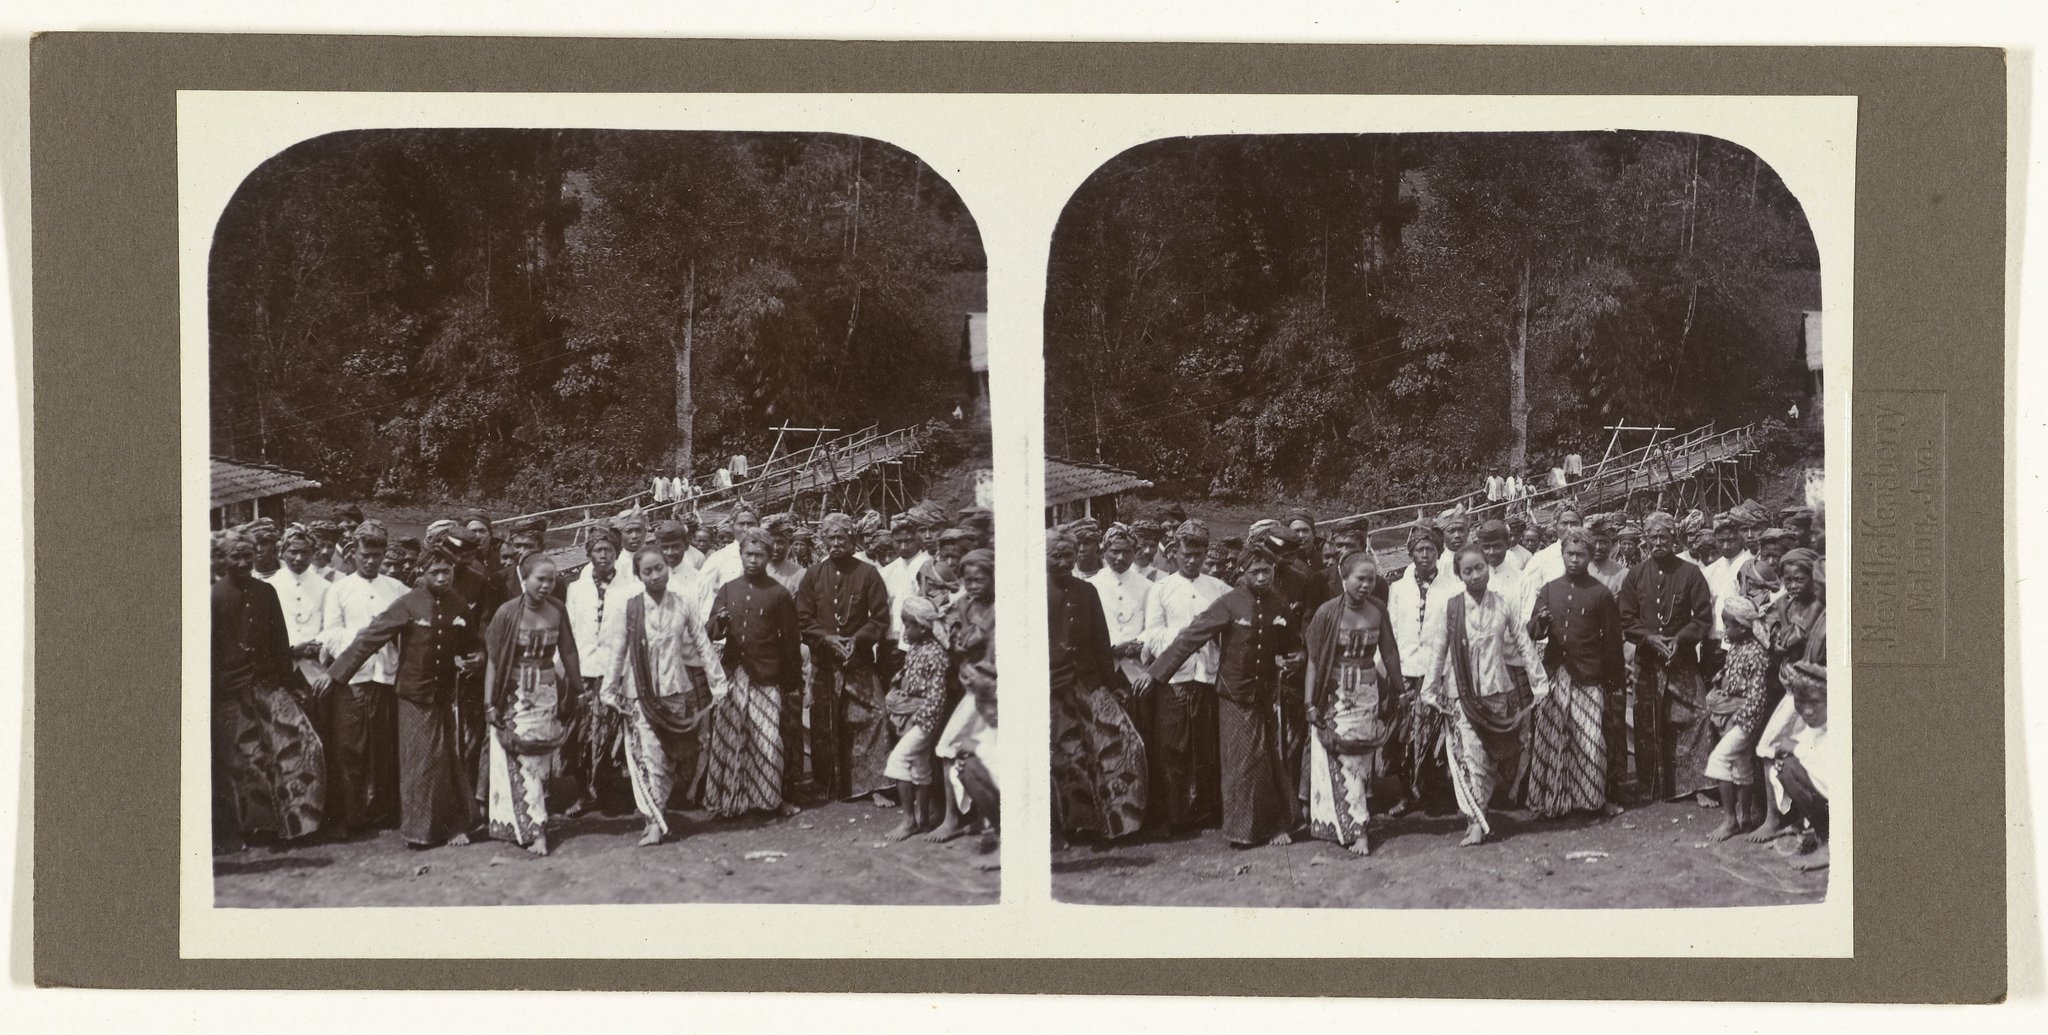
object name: stereograph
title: S 1 No 9. Volksvermaak. Een tandak partij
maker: neville keasberry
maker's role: fotograaf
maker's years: 1866-1944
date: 1900-1935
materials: cardboard, paper, photographic support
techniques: albumen print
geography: malang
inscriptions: signature: ‘Neville Keasberry, Malang (Java)’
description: Een volksfeest waarbij een aantal dames als tandak optreedt. Een tandak is een danseres die danst met veel arm en hoofdbewegingen.